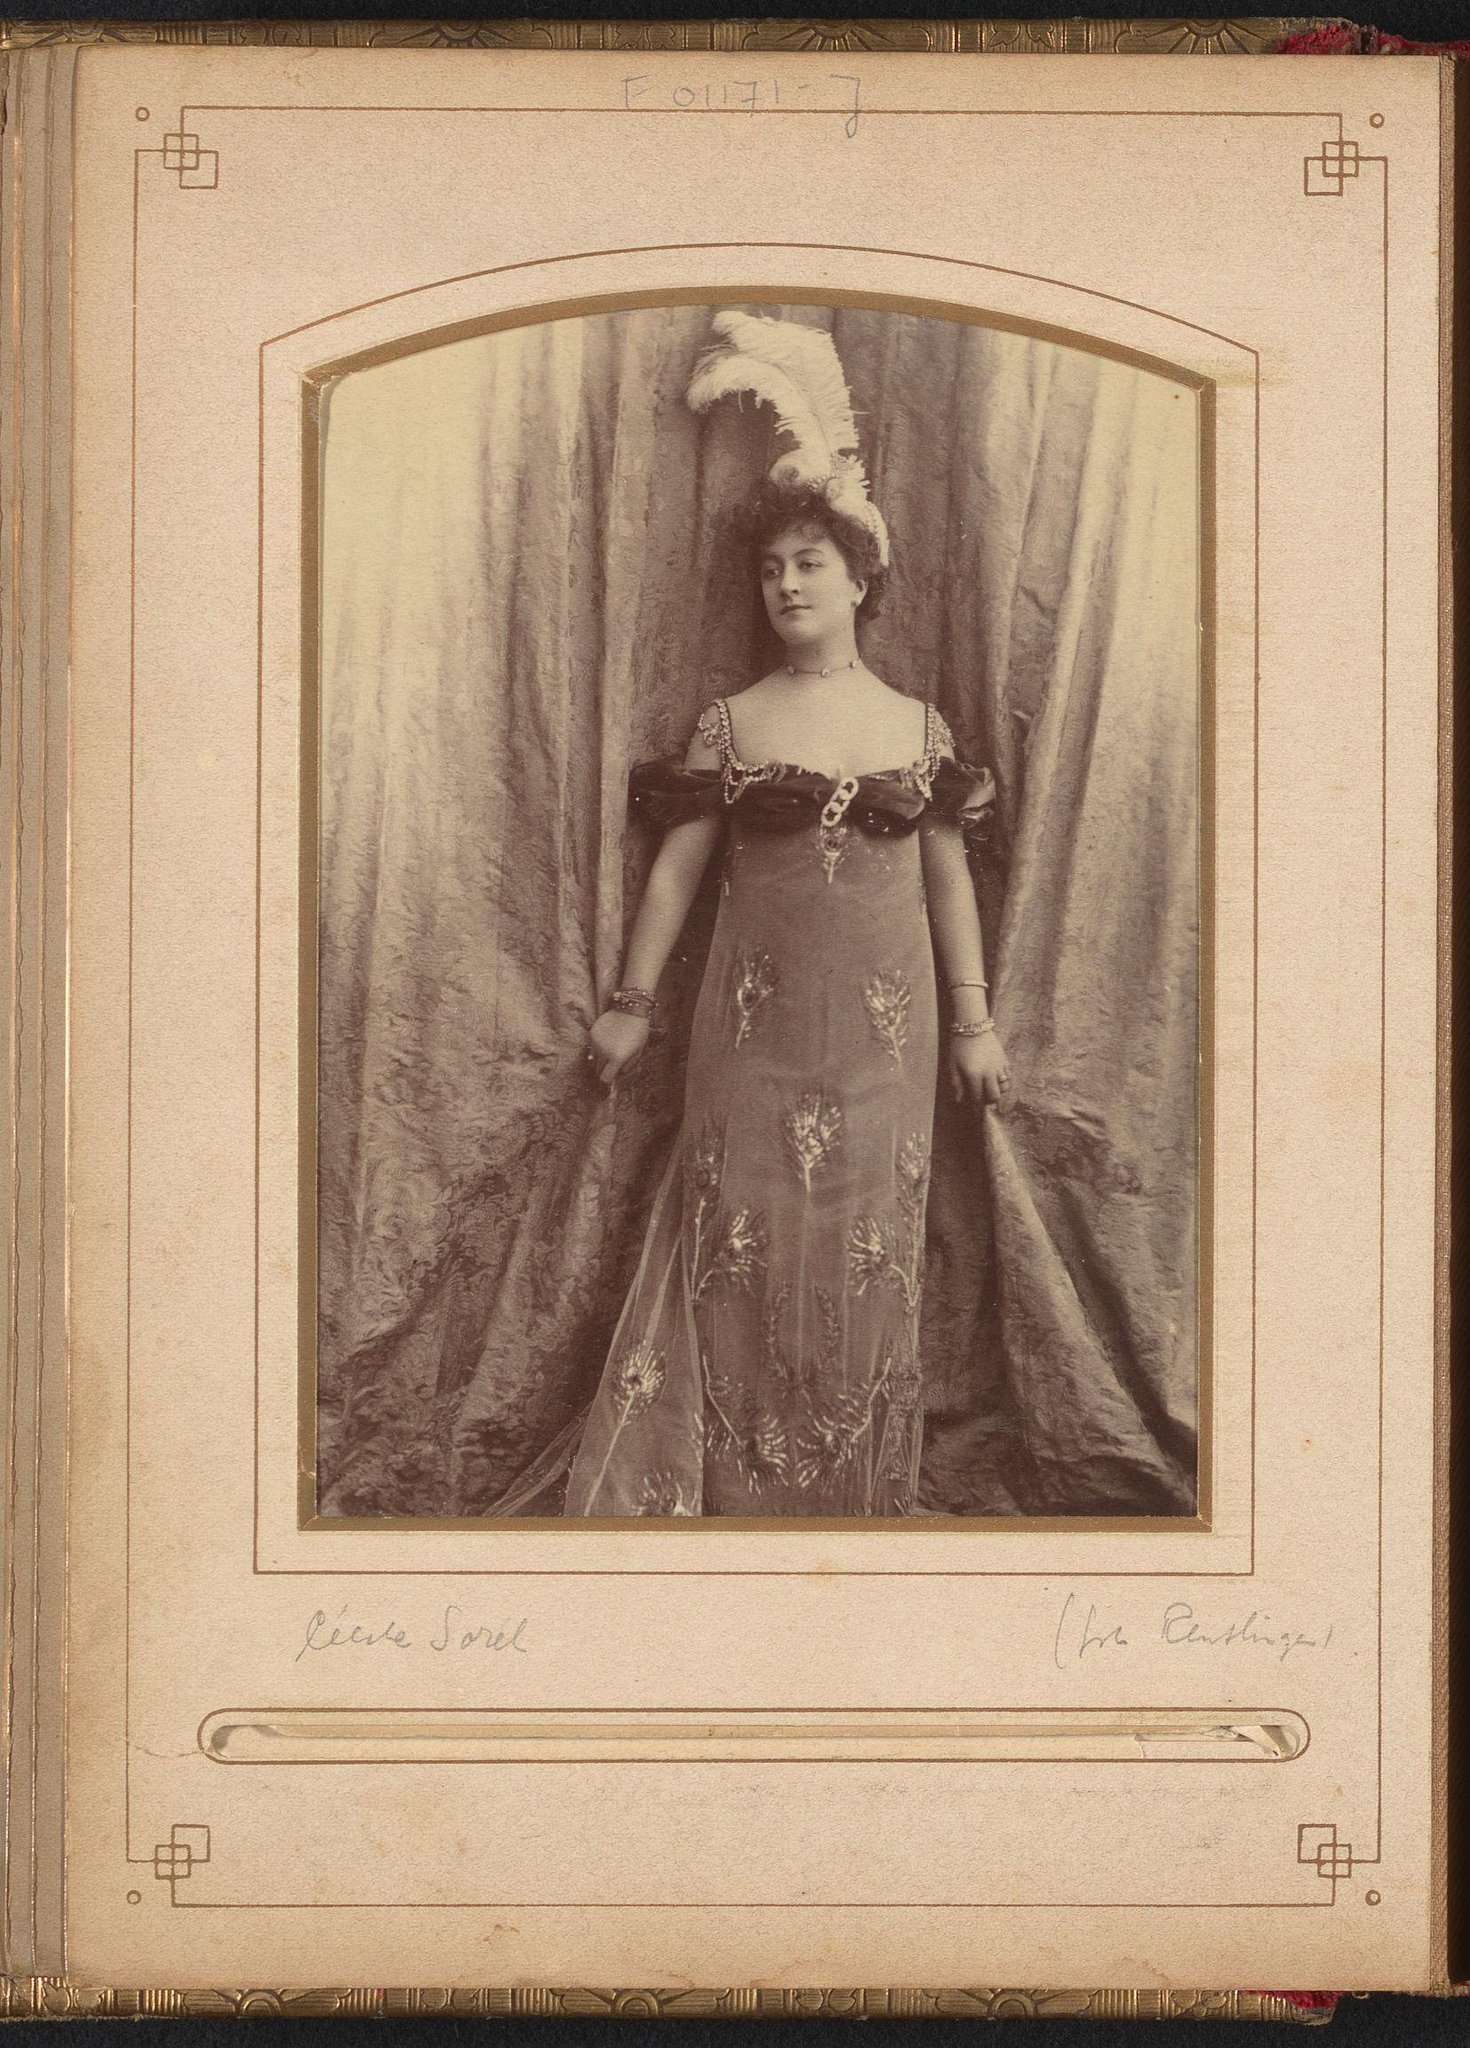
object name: album leaf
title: Portret van Cecile Sorel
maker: charles reutlinger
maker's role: publisher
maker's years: 1816-1880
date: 1890-1910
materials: cardboard, photographic support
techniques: albumen print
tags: adult woman, portrait of actor, actress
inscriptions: inscription: ‘Reutlinger/ Reutlinger’, annotation: ‘Sorel/ Mme de Rovigo’, inscription: ‘16. Médailles/ Reutlinger/ 21. Bould. Montmartre/ Paris/ Ascenseur/ Téléphone’